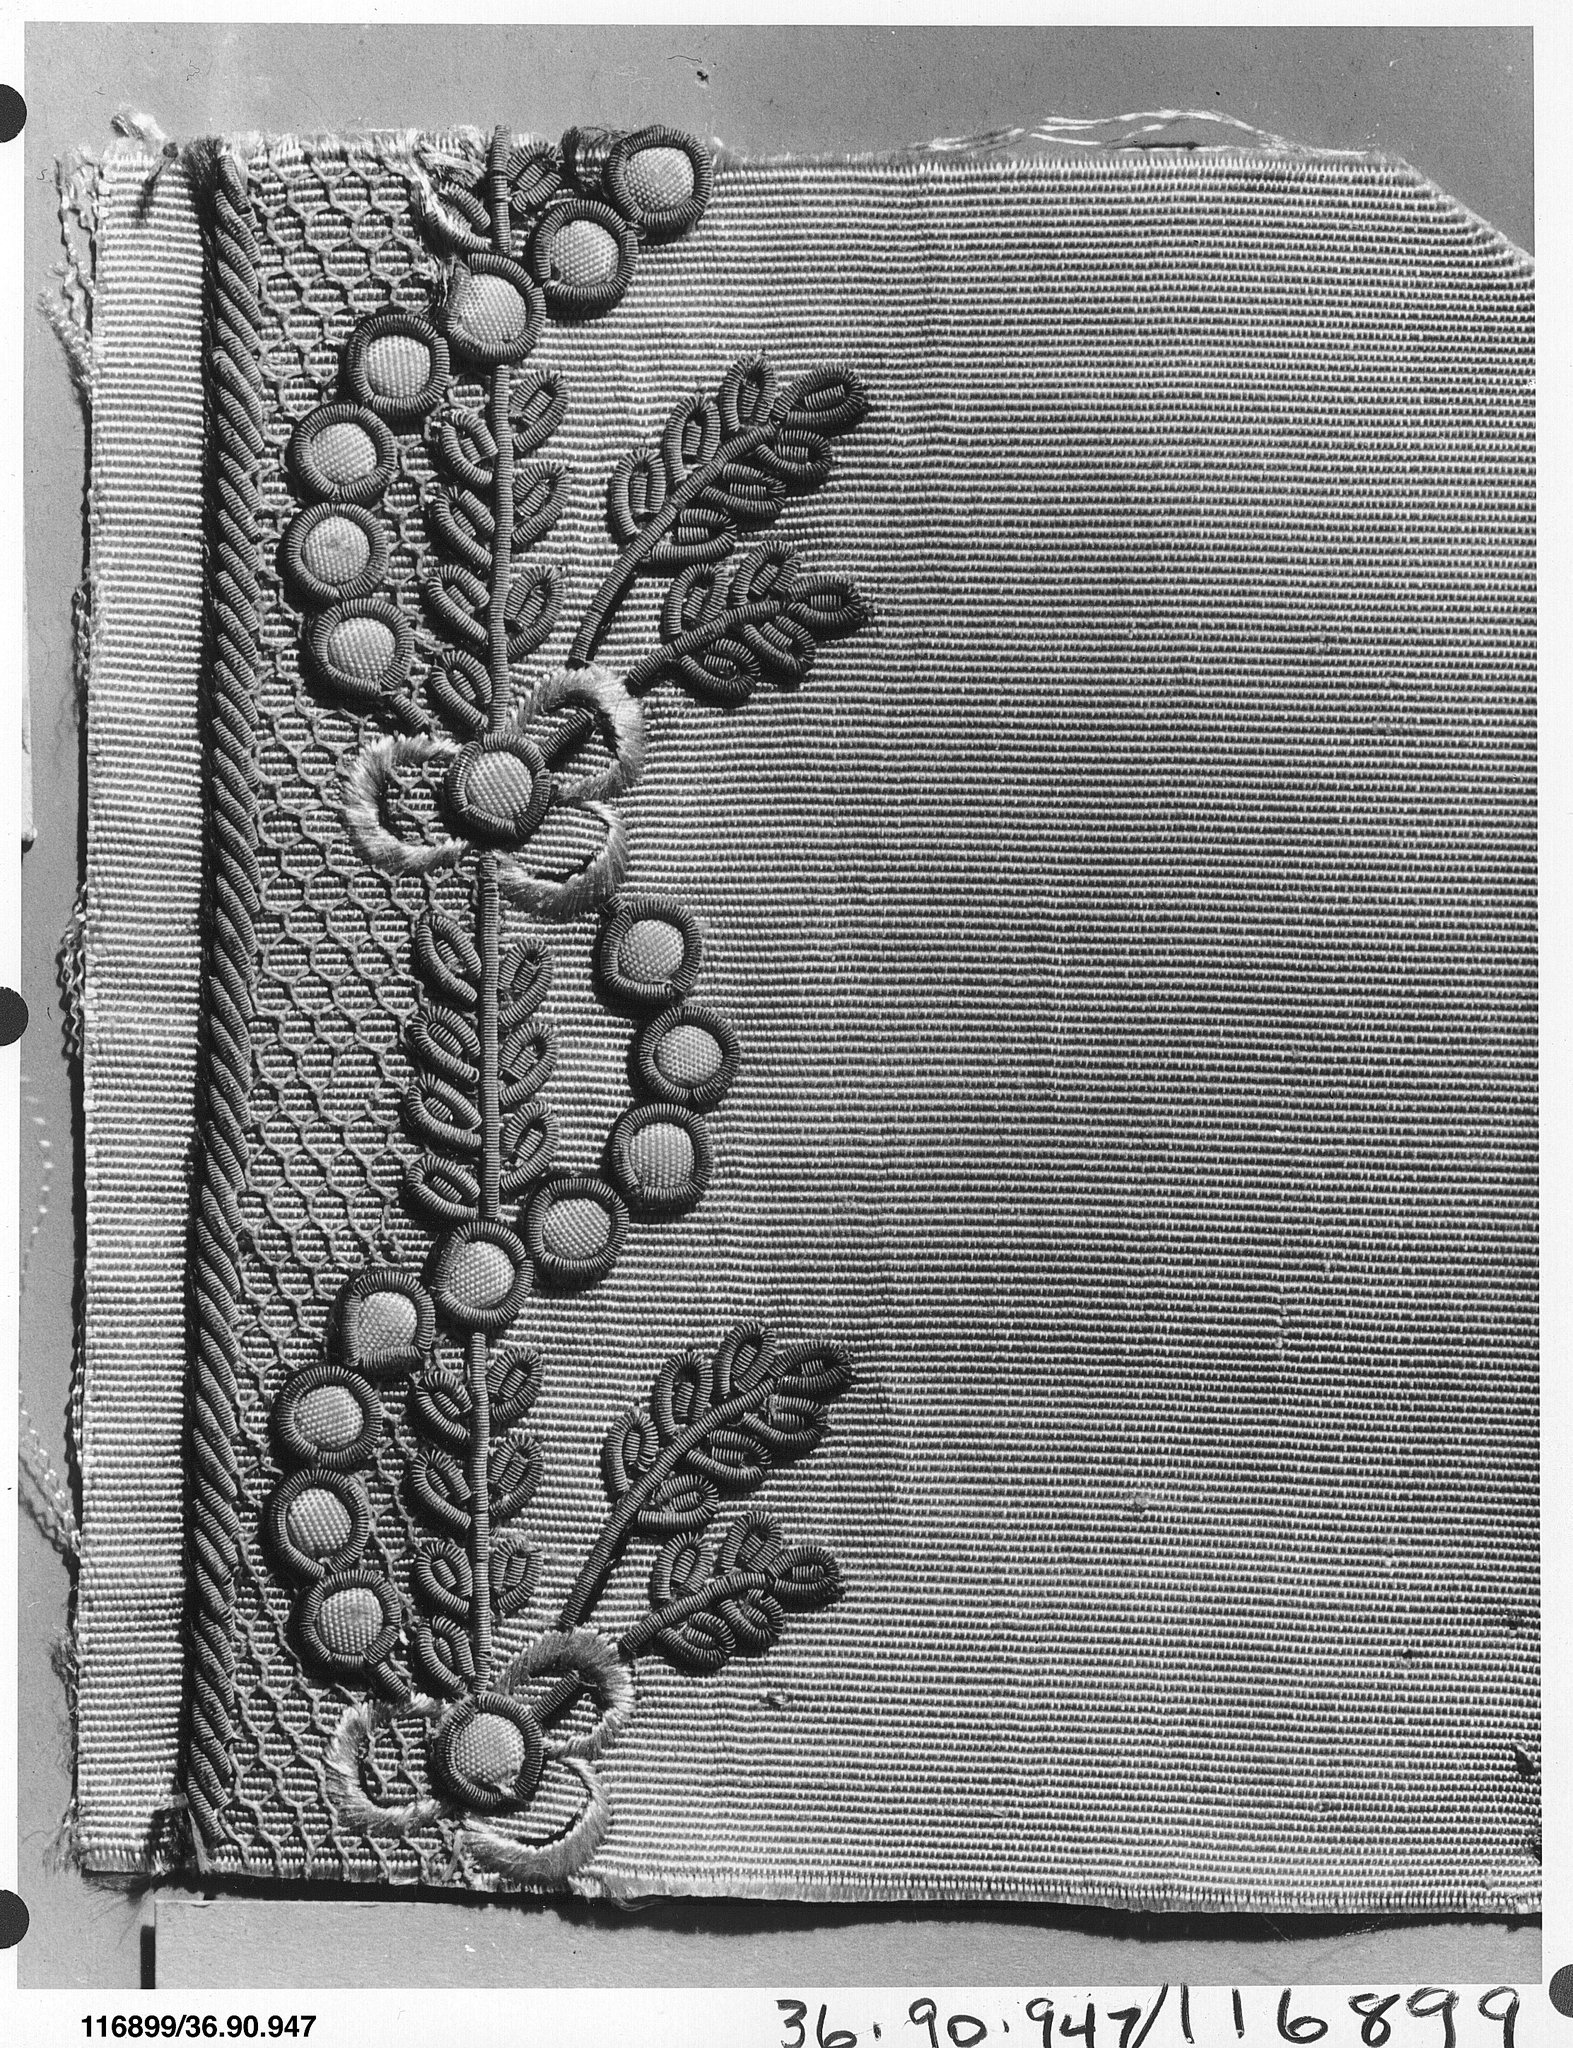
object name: sample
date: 1801-1833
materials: silk